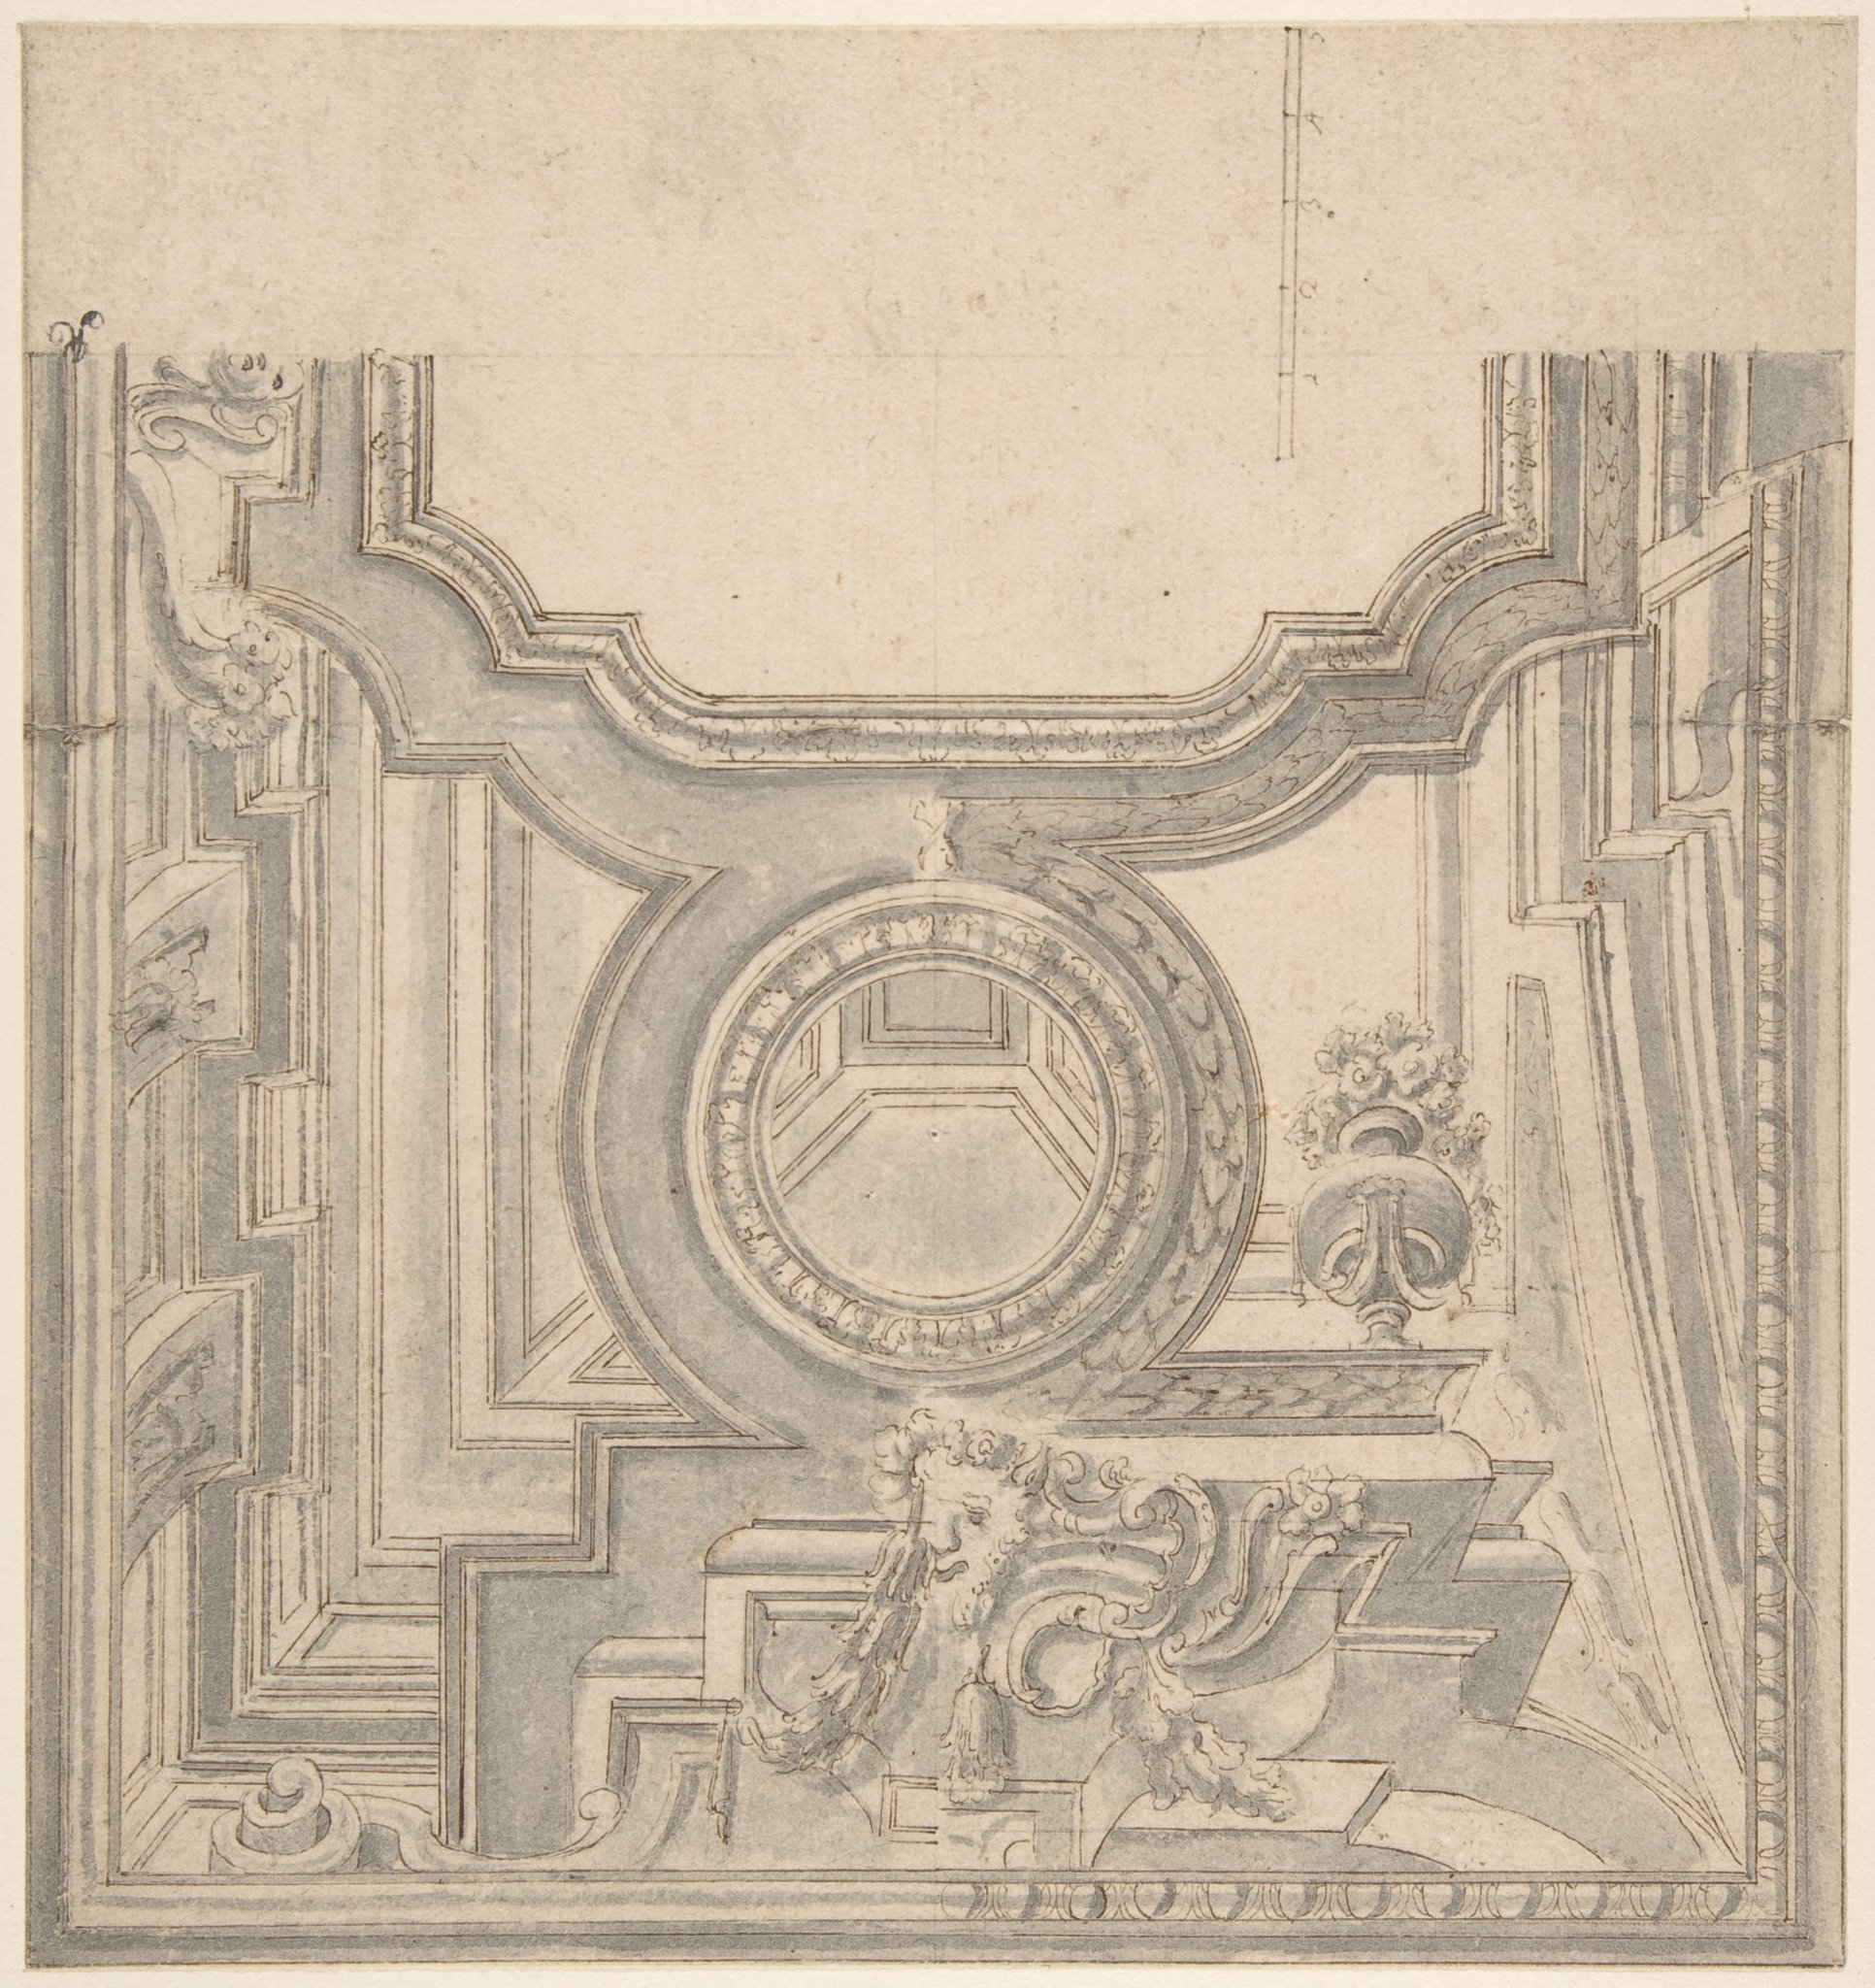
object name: drawing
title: Design for a Ceiling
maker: anonymous, italian, bolognese, 18th century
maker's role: artist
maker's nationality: italian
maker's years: 1700-1800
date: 1701-1800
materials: ink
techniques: pen, wash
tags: architecture